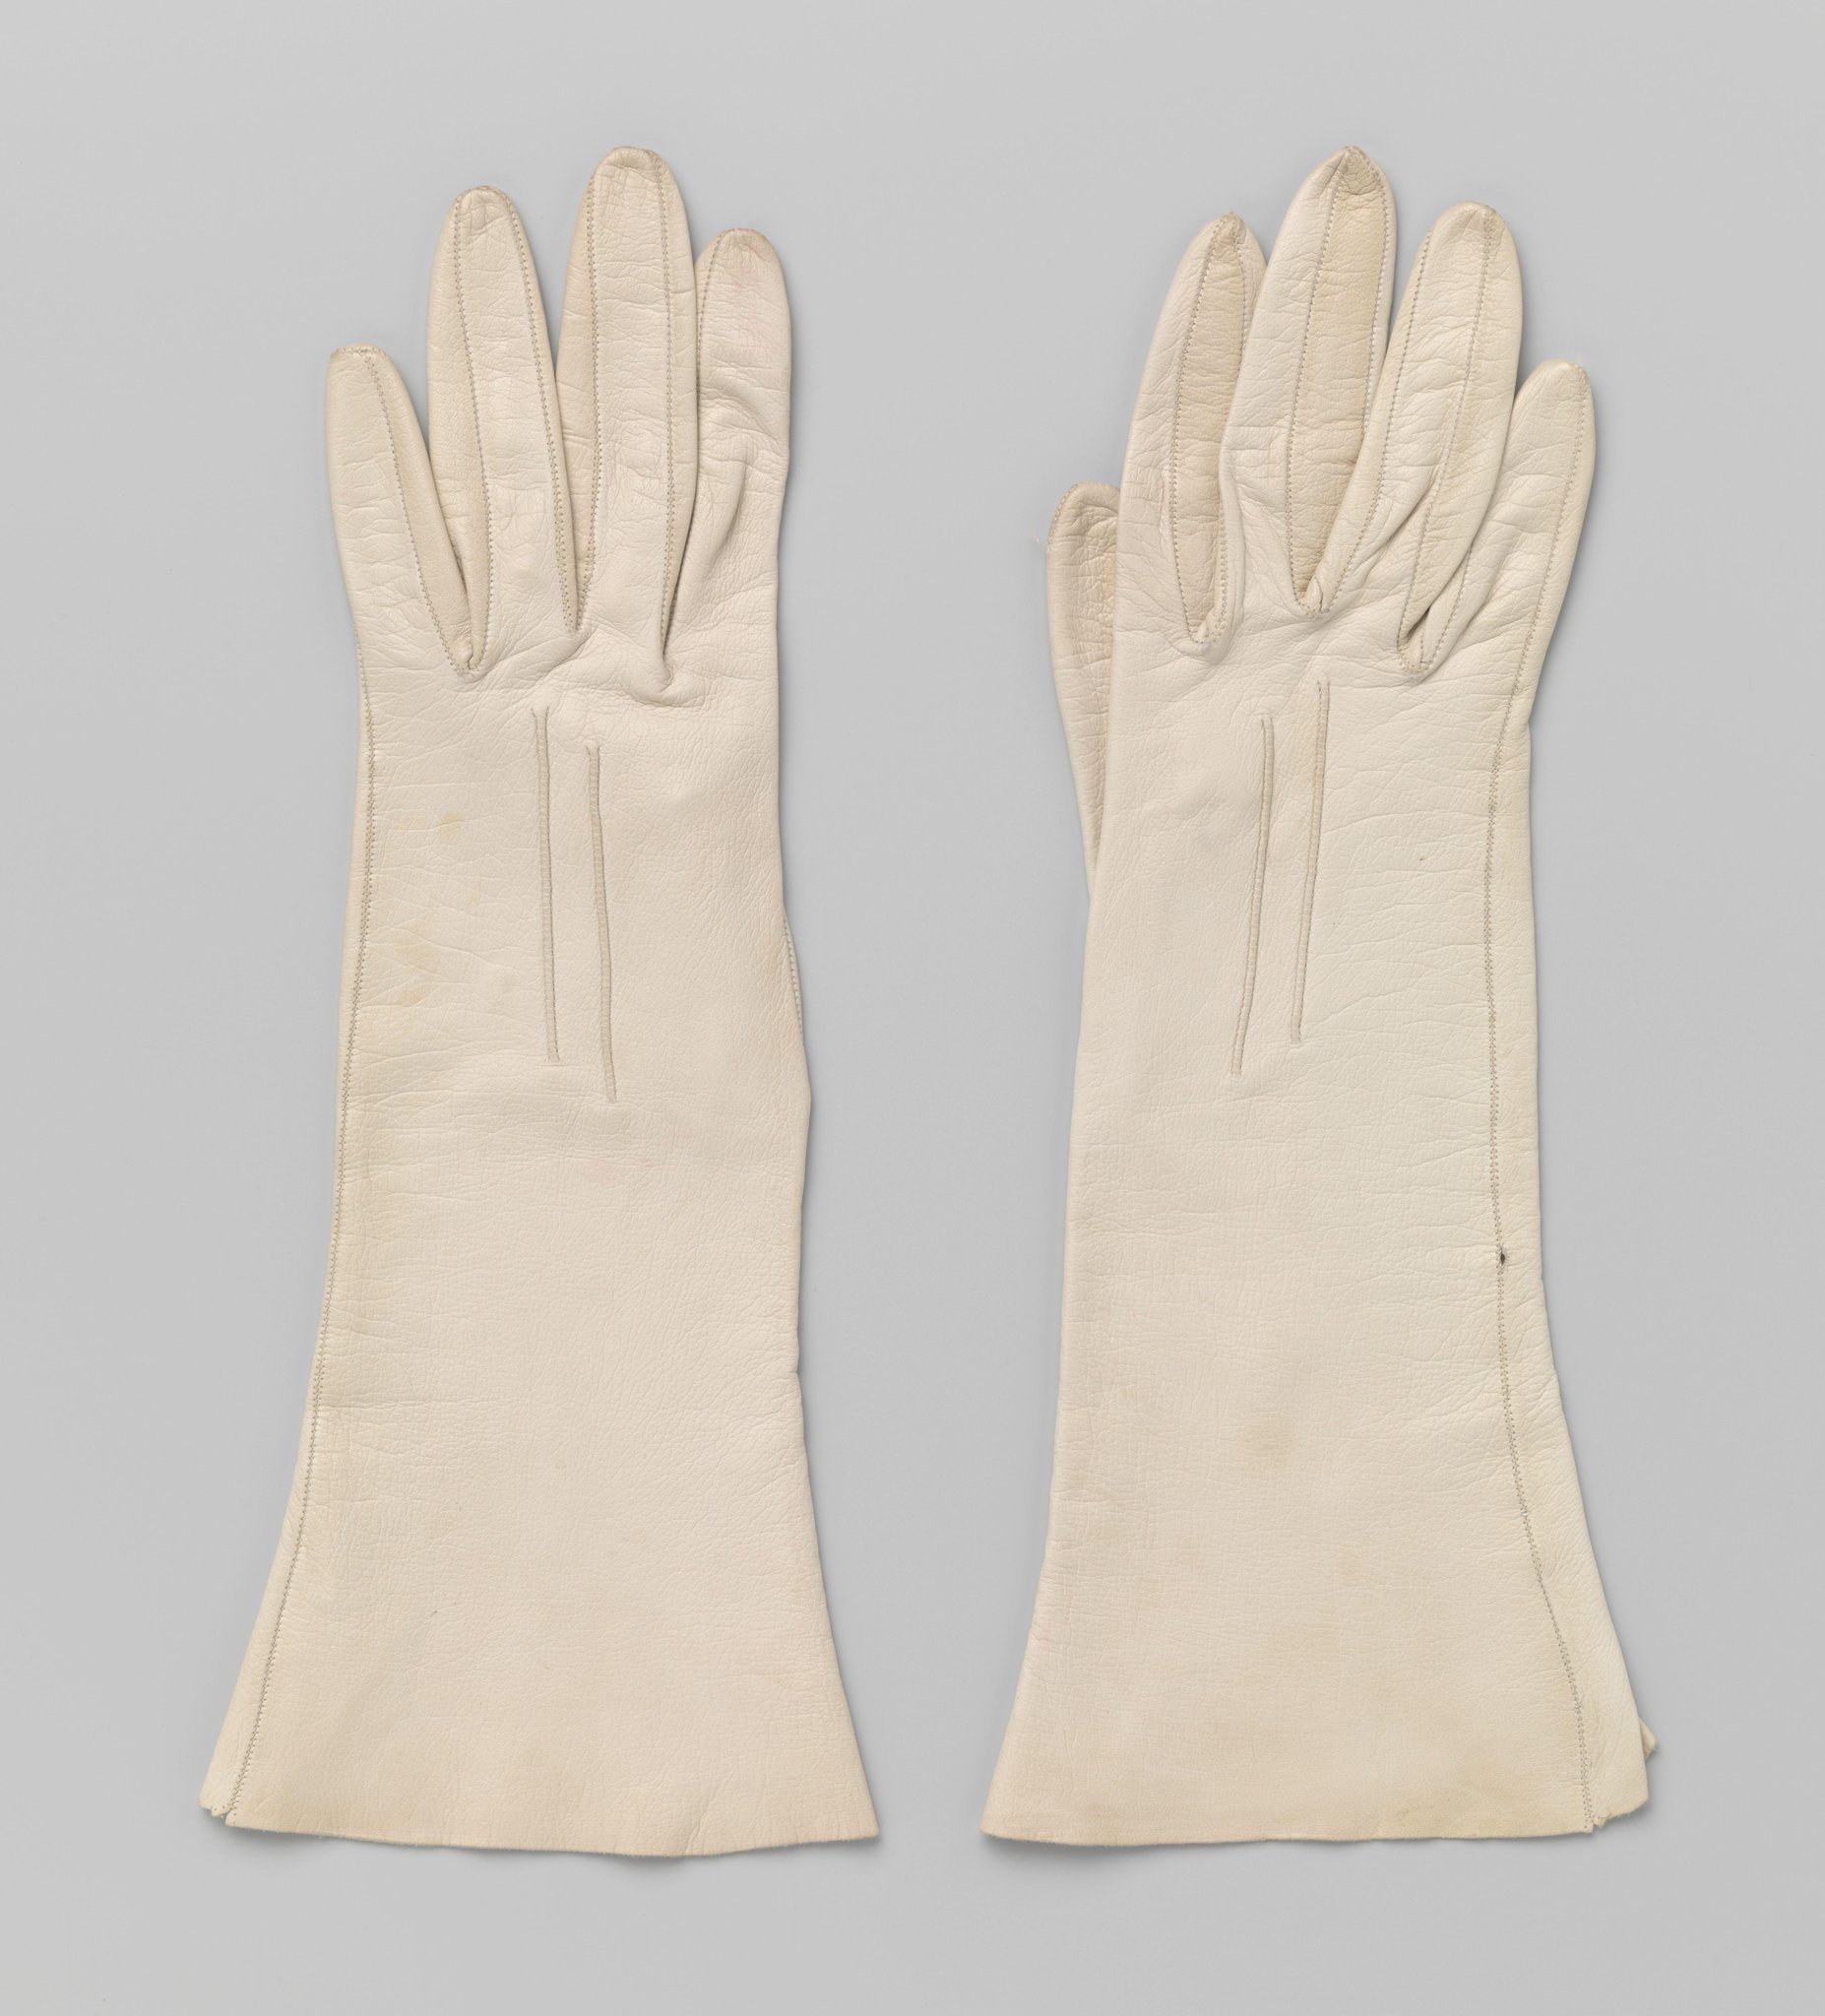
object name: glove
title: Handschoen van grijs beige leer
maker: Anonymous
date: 1900-1915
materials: leather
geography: western europe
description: Linker handschoen van grijs beige leer. op de rug twee uitstralende koorden.